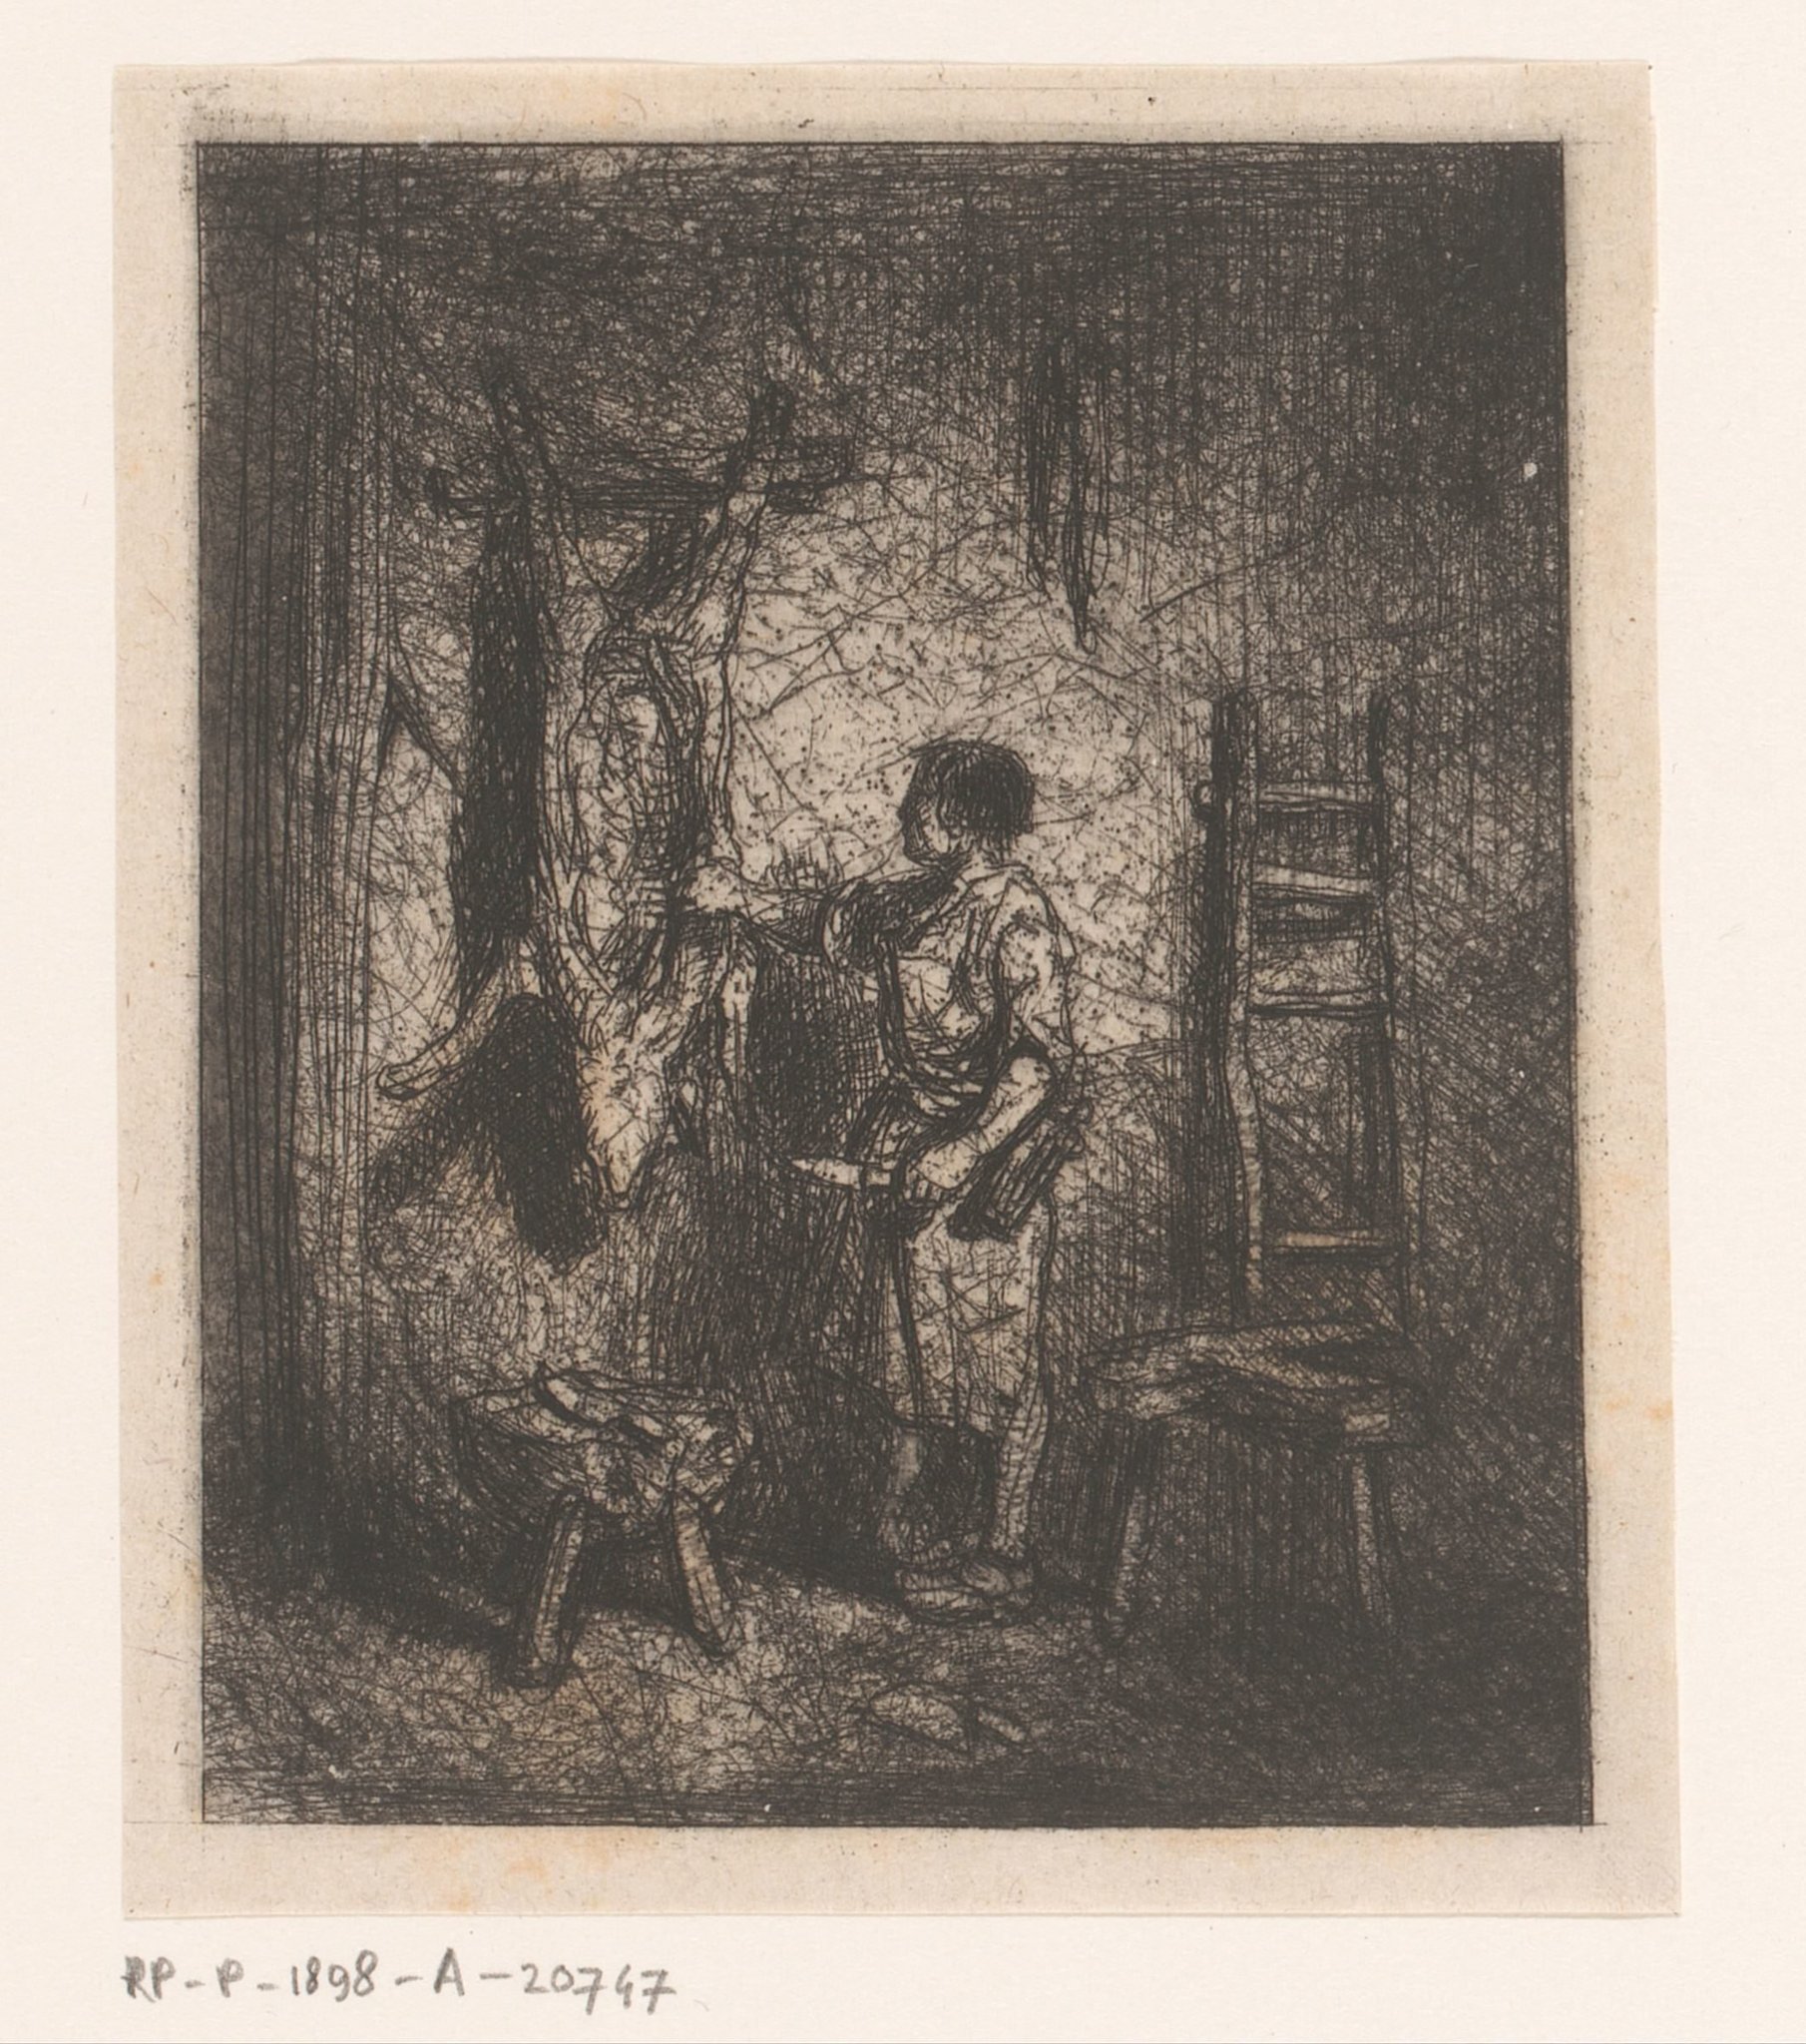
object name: print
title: Varkensslacht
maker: charles emile jacque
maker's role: draughtsman, painter, print maker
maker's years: 1813-1894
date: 1844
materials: paper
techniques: etching, intaglio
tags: slaughtered ox or pig, butcher, slaughterman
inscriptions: collector's mark: Lugt 964